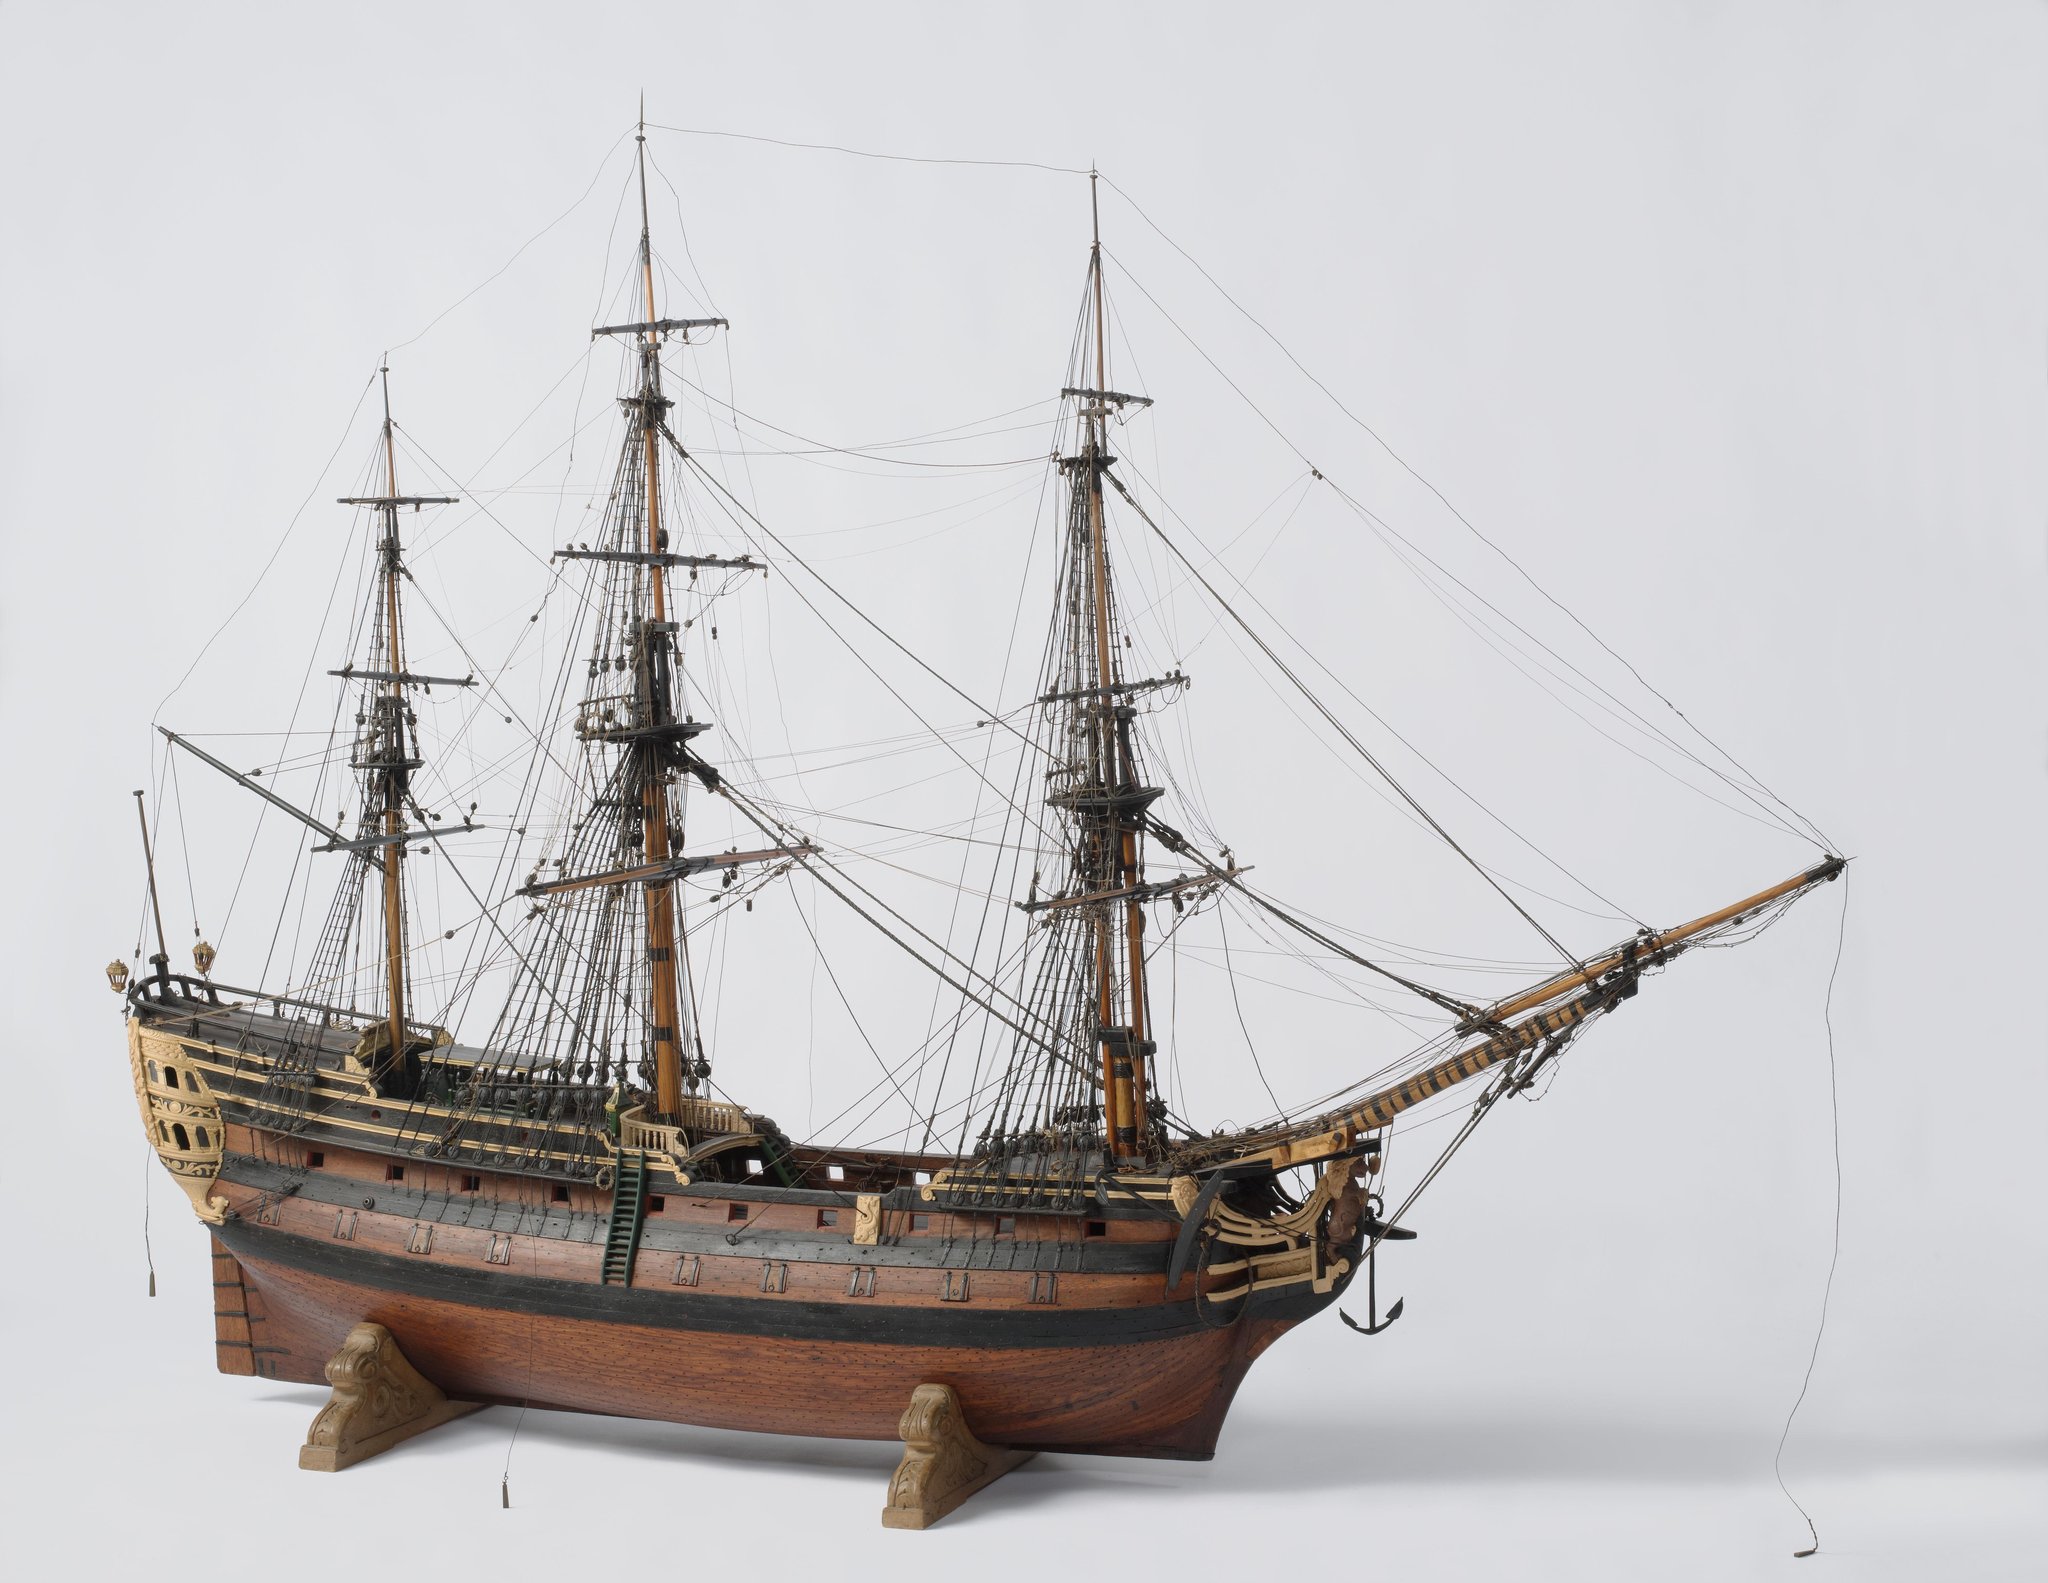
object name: show model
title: Model of a 40-Gun Dutch East Indiaman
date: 1780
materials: brass, glass, iron, leather, fiber, wood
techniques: polychromy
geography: amsterdam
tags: ship-model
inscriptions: inscription, on the stern: ‘17 VERGELIJKING.80.’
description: De beheerders van de Marinemodellenkamer lieten niet alleen nieuwe modellen bouwen, maar brachten soms ook ‘verbeteringen’ aan op bestaande modellen. Dit scheepsmodel van een 18de-eeuwse Oost-Indiëvaarder is een eeuw later door J.P. Asmus van een noodfokkenmast en bliksemafleiders voorzien. De VOC had geen schip Vergelijking in gebruik; de naam doet vermoeden dat het model nieuwe scheepsbouwtechnieken inzichtelijk moest maken.